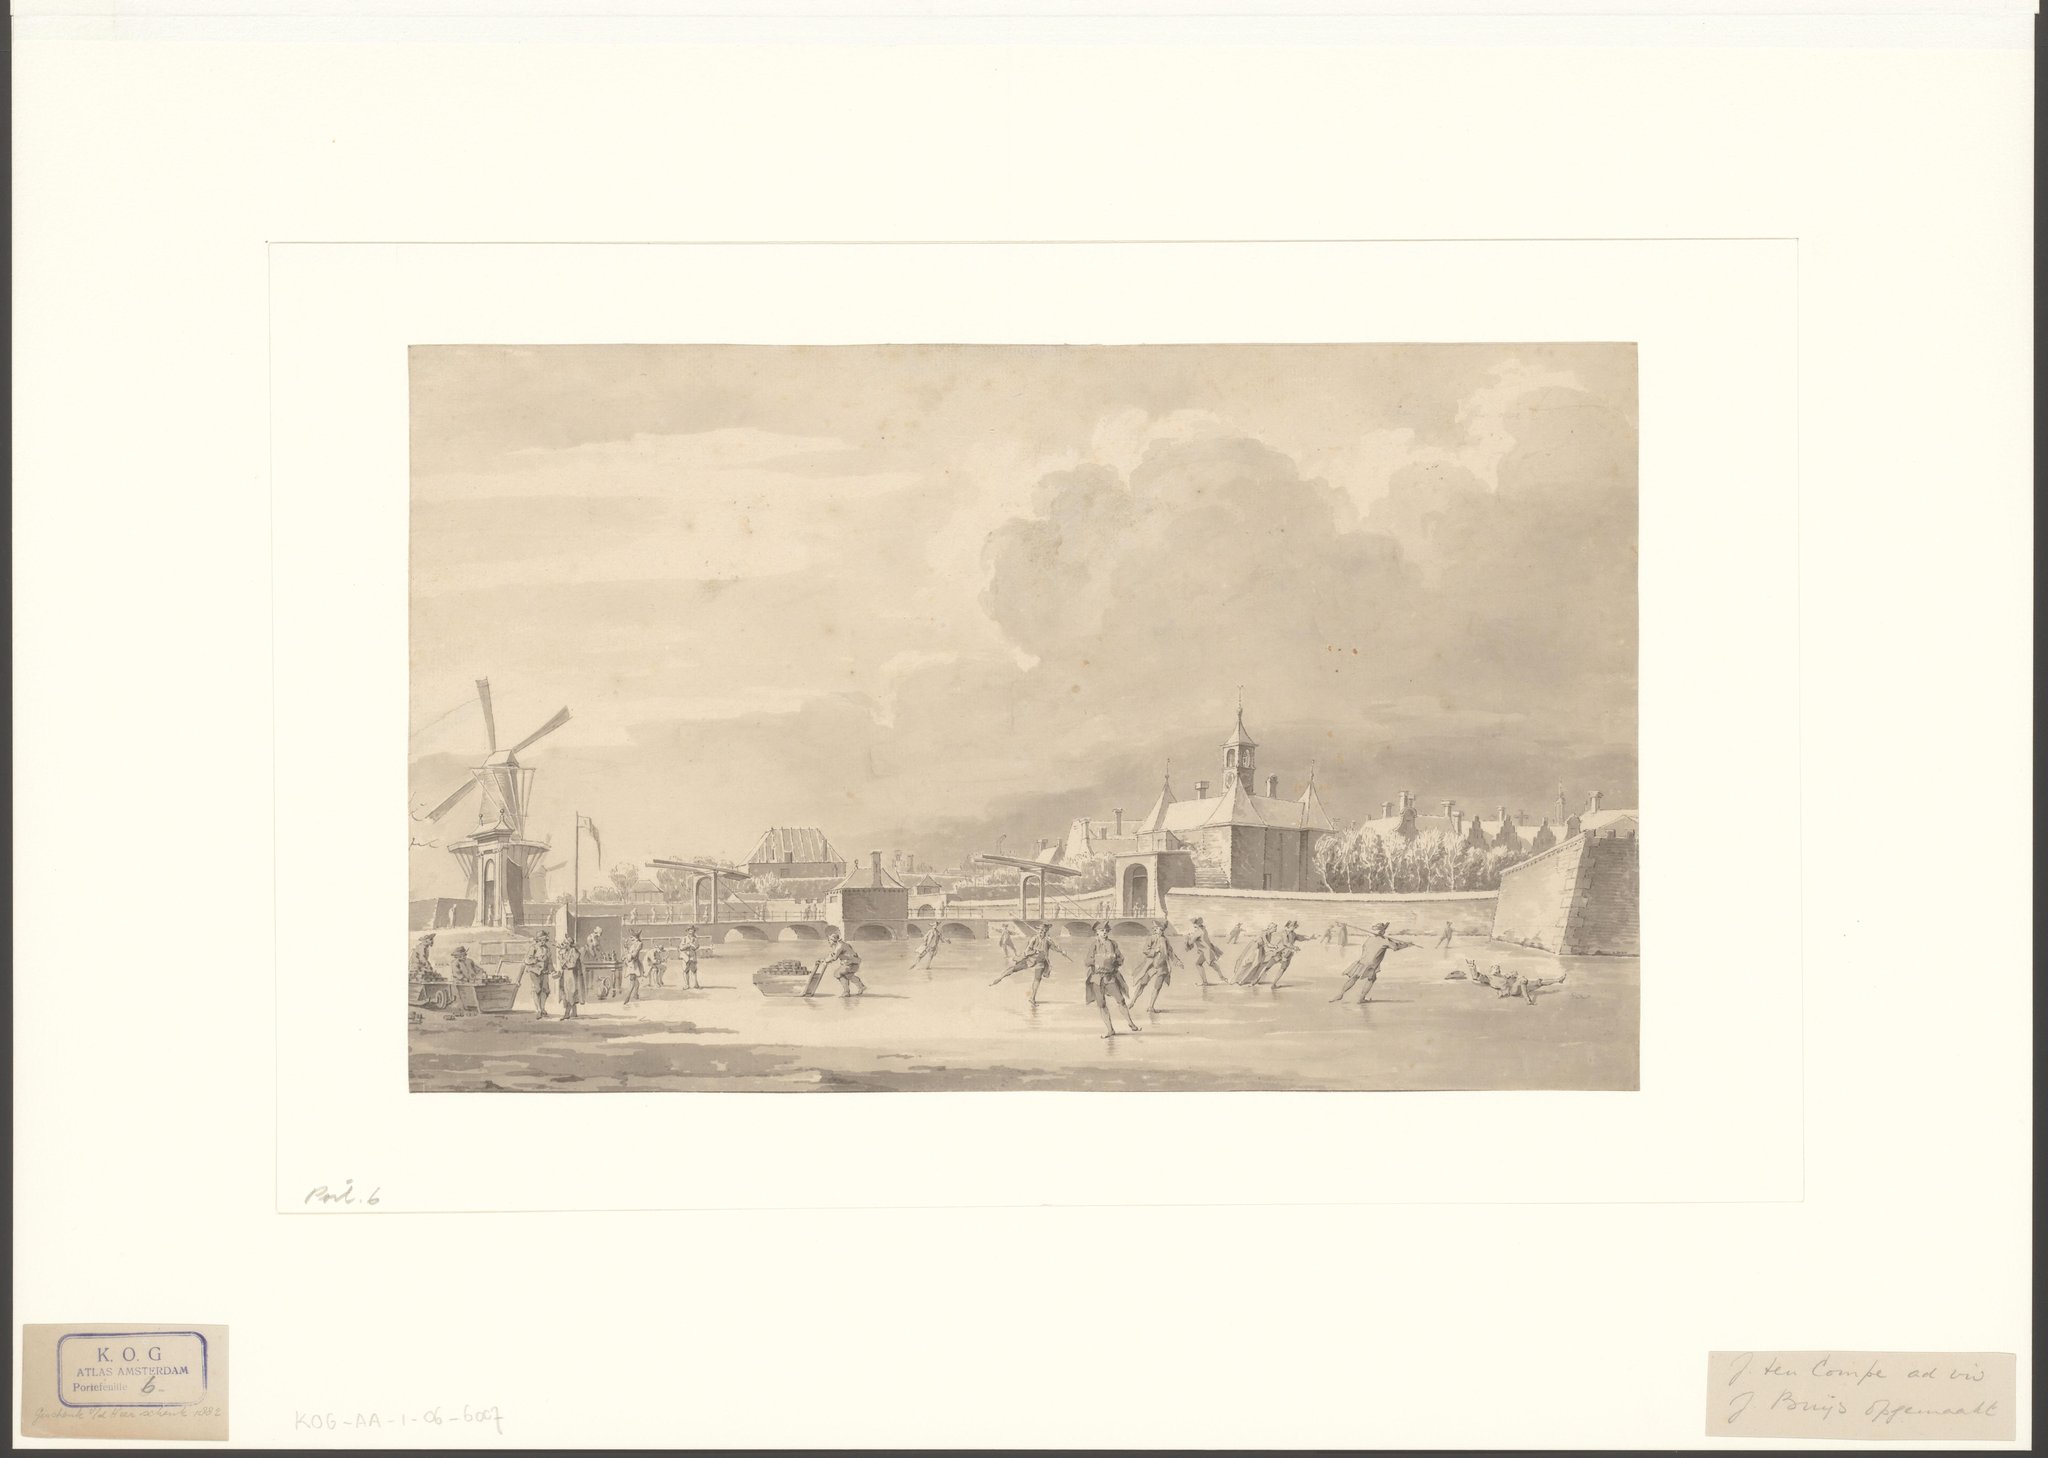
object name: drawing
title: Gezicht op schaatsers bij de Leidsepoort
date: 1734-1761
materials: ink, paper, pencil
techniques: brush, pen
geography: amsterdam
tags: city-view in general; 'veduta', winter landscape; landscape symbolizing winter (the four seasons of the year), skates (winter sports), city-gate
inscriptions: inscription: ‘Port. 6’, inscription: ‘[...] ten Compe ad. viv. / J Buijs opgema[...]’, collector's mark: ‘6 / Geschenk van de Heer schenk 1882’ Lugt 1641b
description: Onderwerpsrubriek binnen de Atlas Amsterdam: Buitensingel, Gezichten langs en op de Stadsvest van Raampoort tot Zeeburgerdijk.